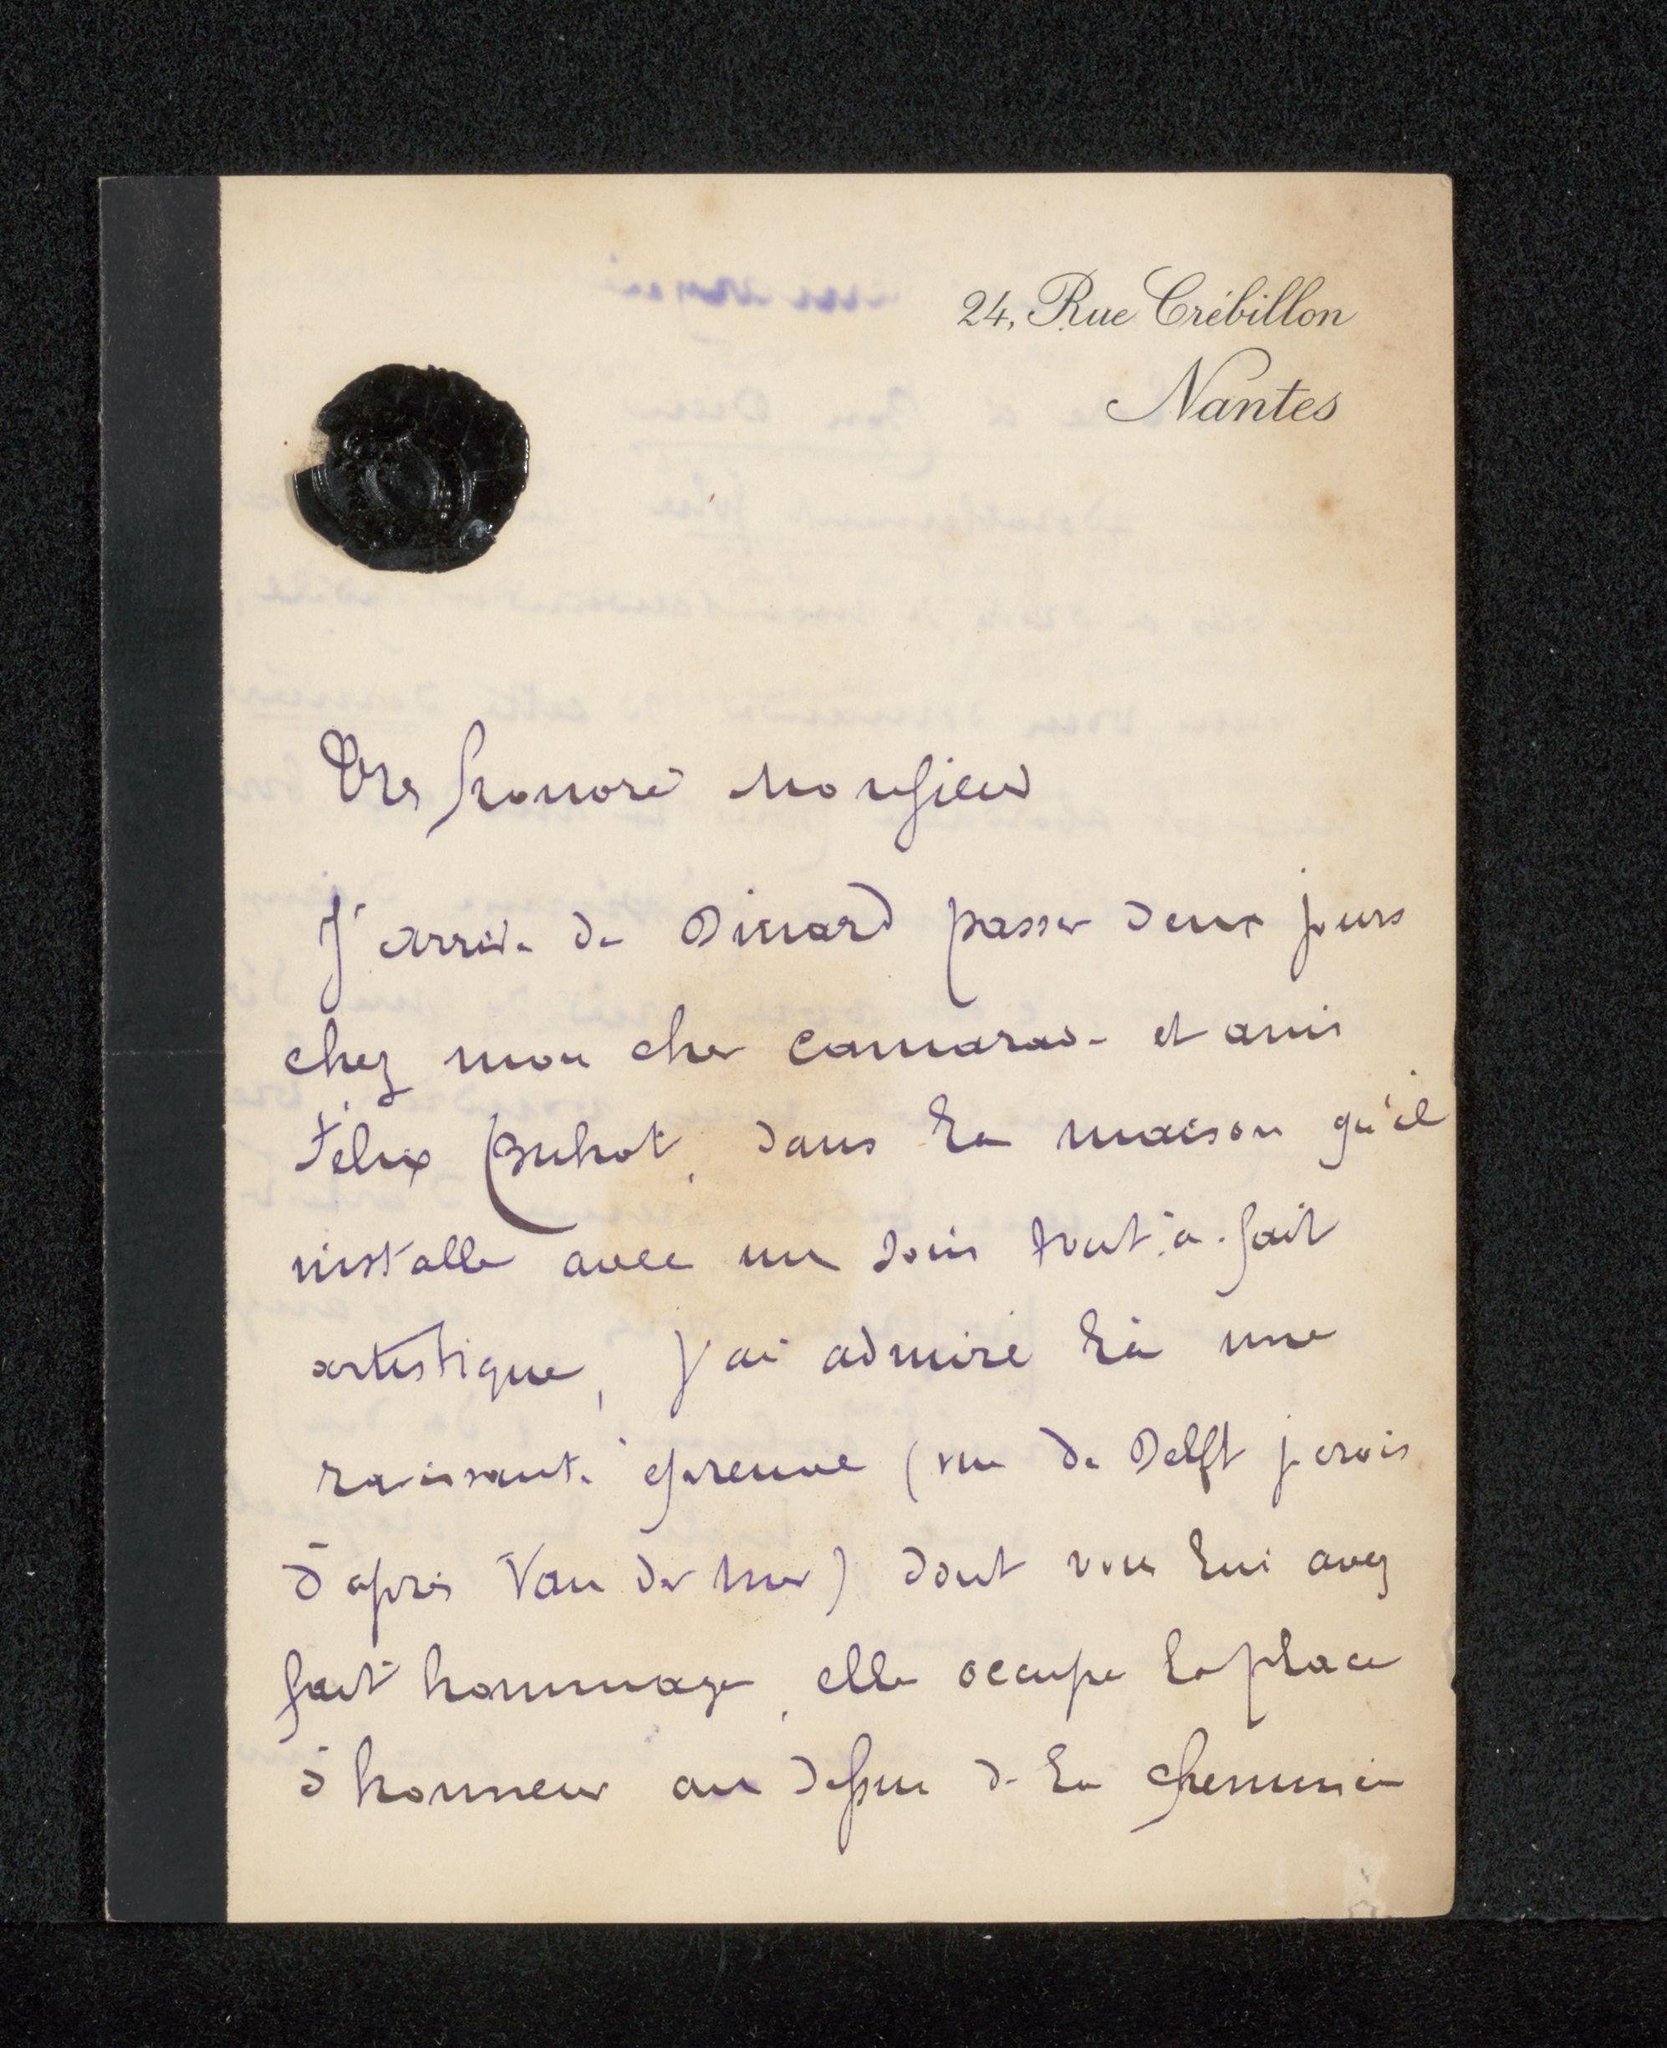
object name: letter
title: Brief aan Philip Zilcken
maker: gustave bourcard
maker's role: verzamelaar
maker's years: 1846-1925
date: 1890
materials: ink, paper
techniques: pen, printing, writing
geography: nantes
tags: paris, print maker, félix hilaire buhot, the hague, painter, draughtsman, philip zilcken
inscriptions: seal: ‘ST’, collector's mark: ‘RPK’